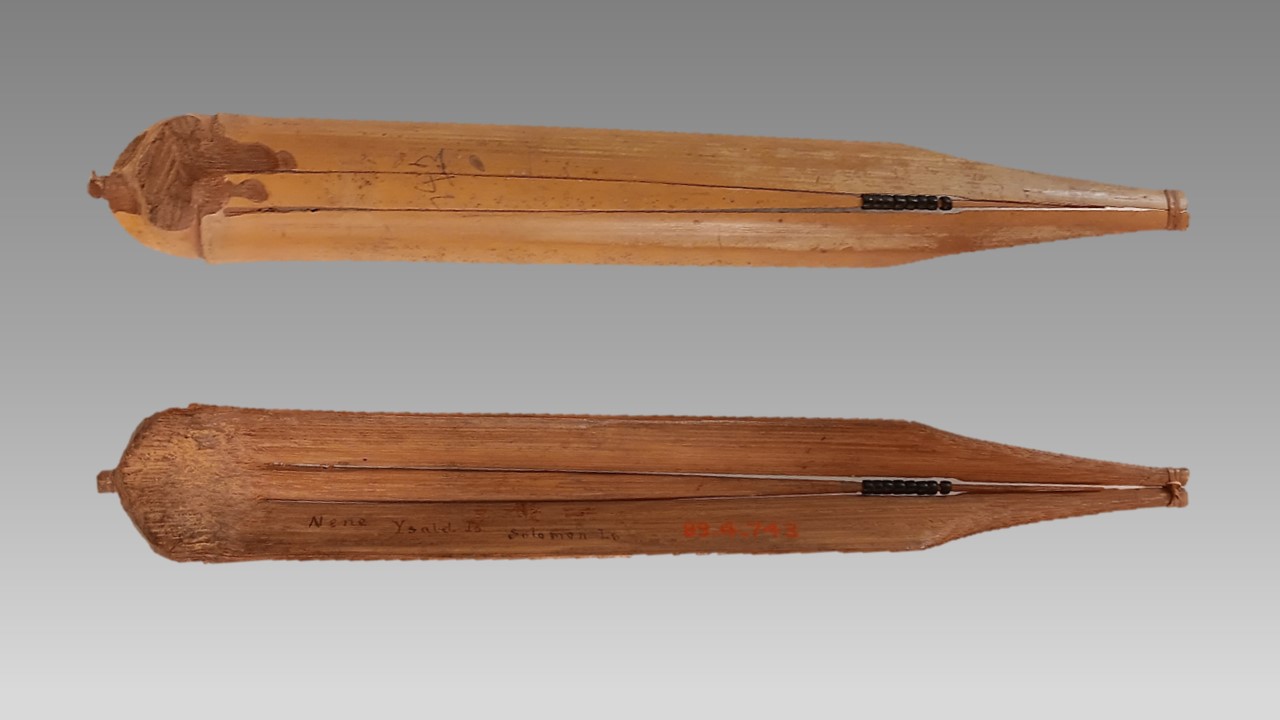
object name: neve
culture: melanesian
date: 1801-1900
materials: bamboo, fiber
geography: solomon islands